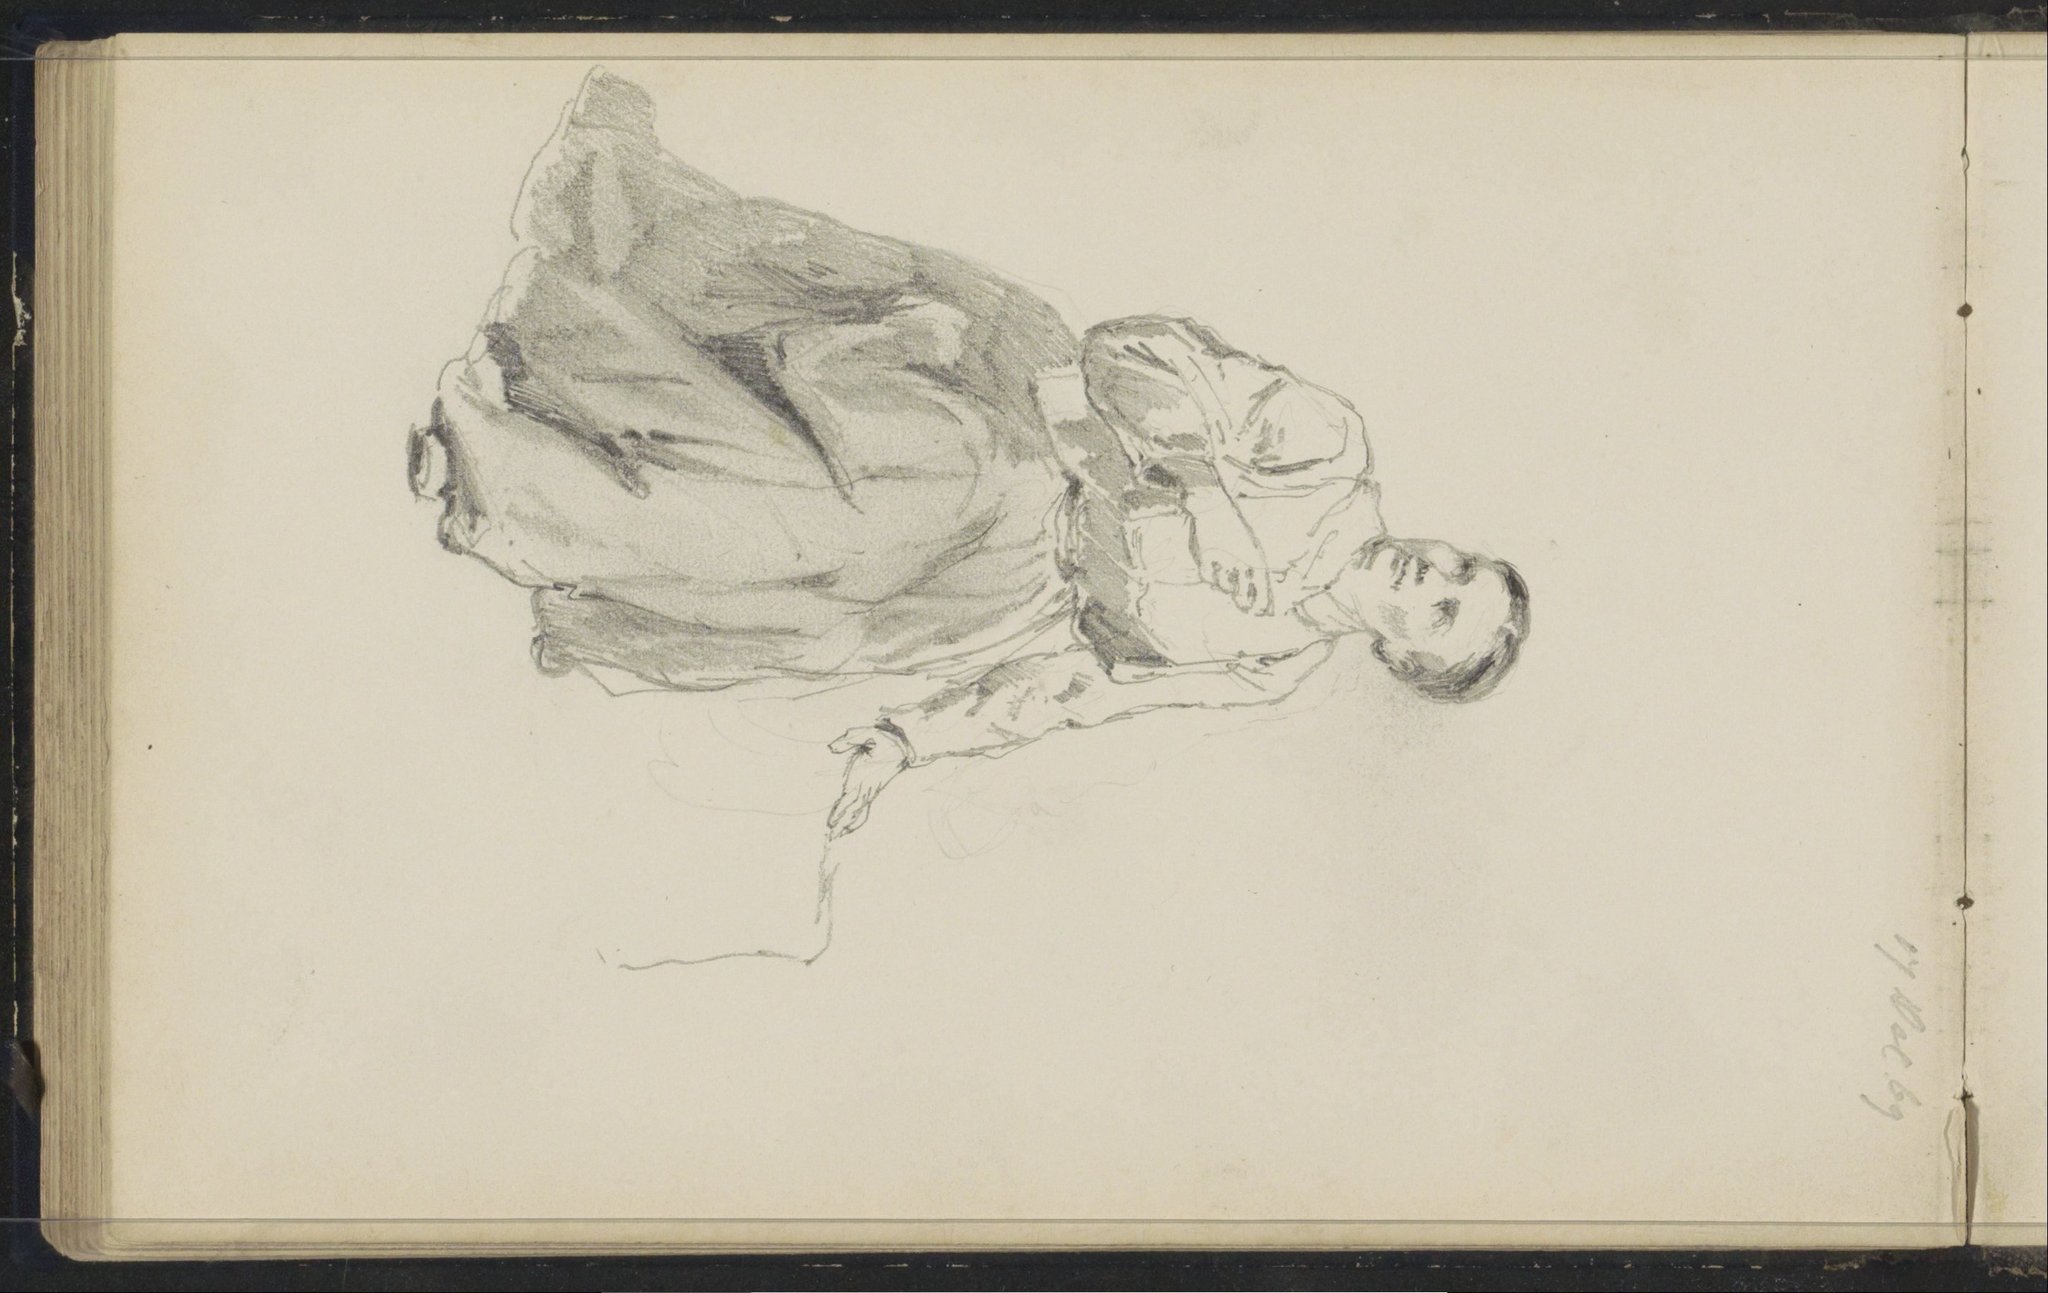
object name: sketchbook leaf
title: Zittende vrouw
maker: cornelis springer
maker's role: draughtsman, painter, print maker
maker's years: 1817-1891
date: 1869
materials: paper, pencil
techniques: stumping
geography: netherlands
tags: adult woman, sitting on an elevation - aa - female human figure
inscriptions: date: ‘17 Dec 69’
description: Zittende vrouw. Blad 36 verso uit een schetsboek met 40 bladen, vervaardigd in Woerden en Gouda.